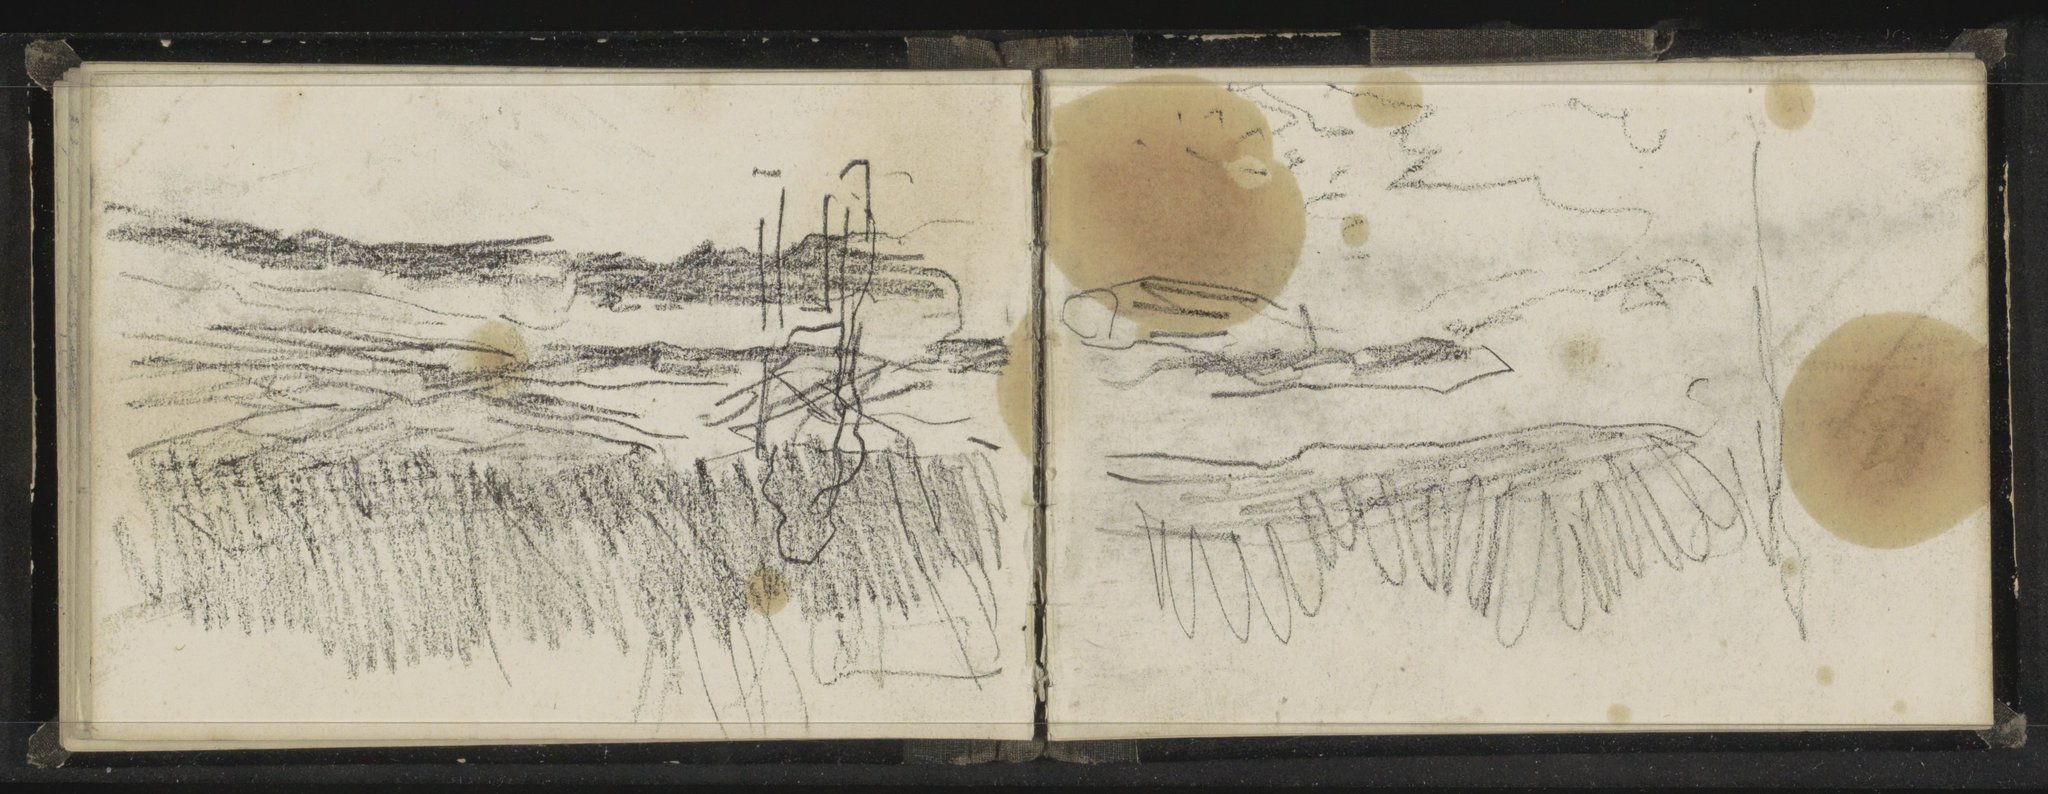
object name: sketchbook leaf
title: Landschap met een staande figuur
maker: anton mauve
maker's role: draughtsman, painter, print maker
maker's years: 1838-1888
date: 1848-1888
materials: chalk, paper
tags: landscapes (+ landscape with figures, staffage)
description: Blad 28 verso en 29 recto uit een schetsboek met 33 bladen.